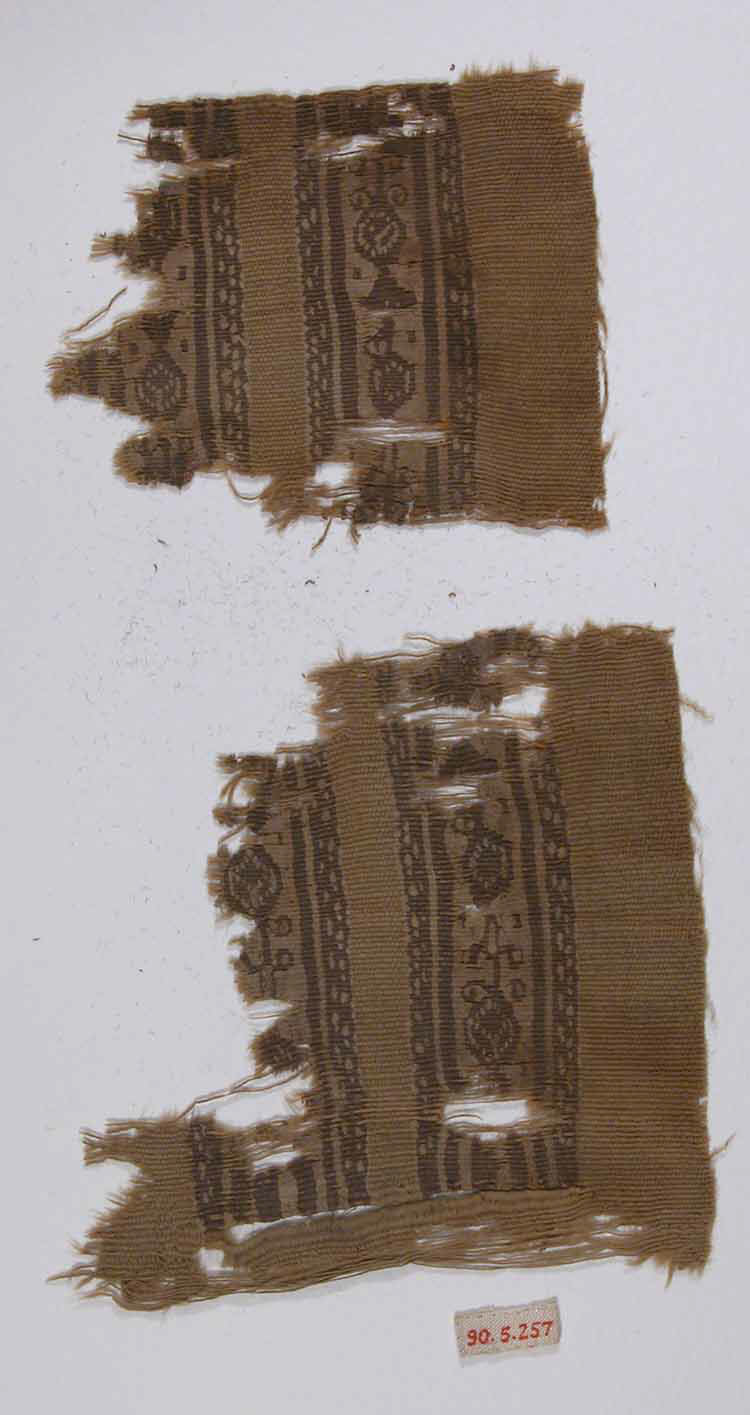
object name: textile fragment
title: Fragment of a Sleeve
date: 301-500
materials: linen, wool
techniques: weave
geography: egypt